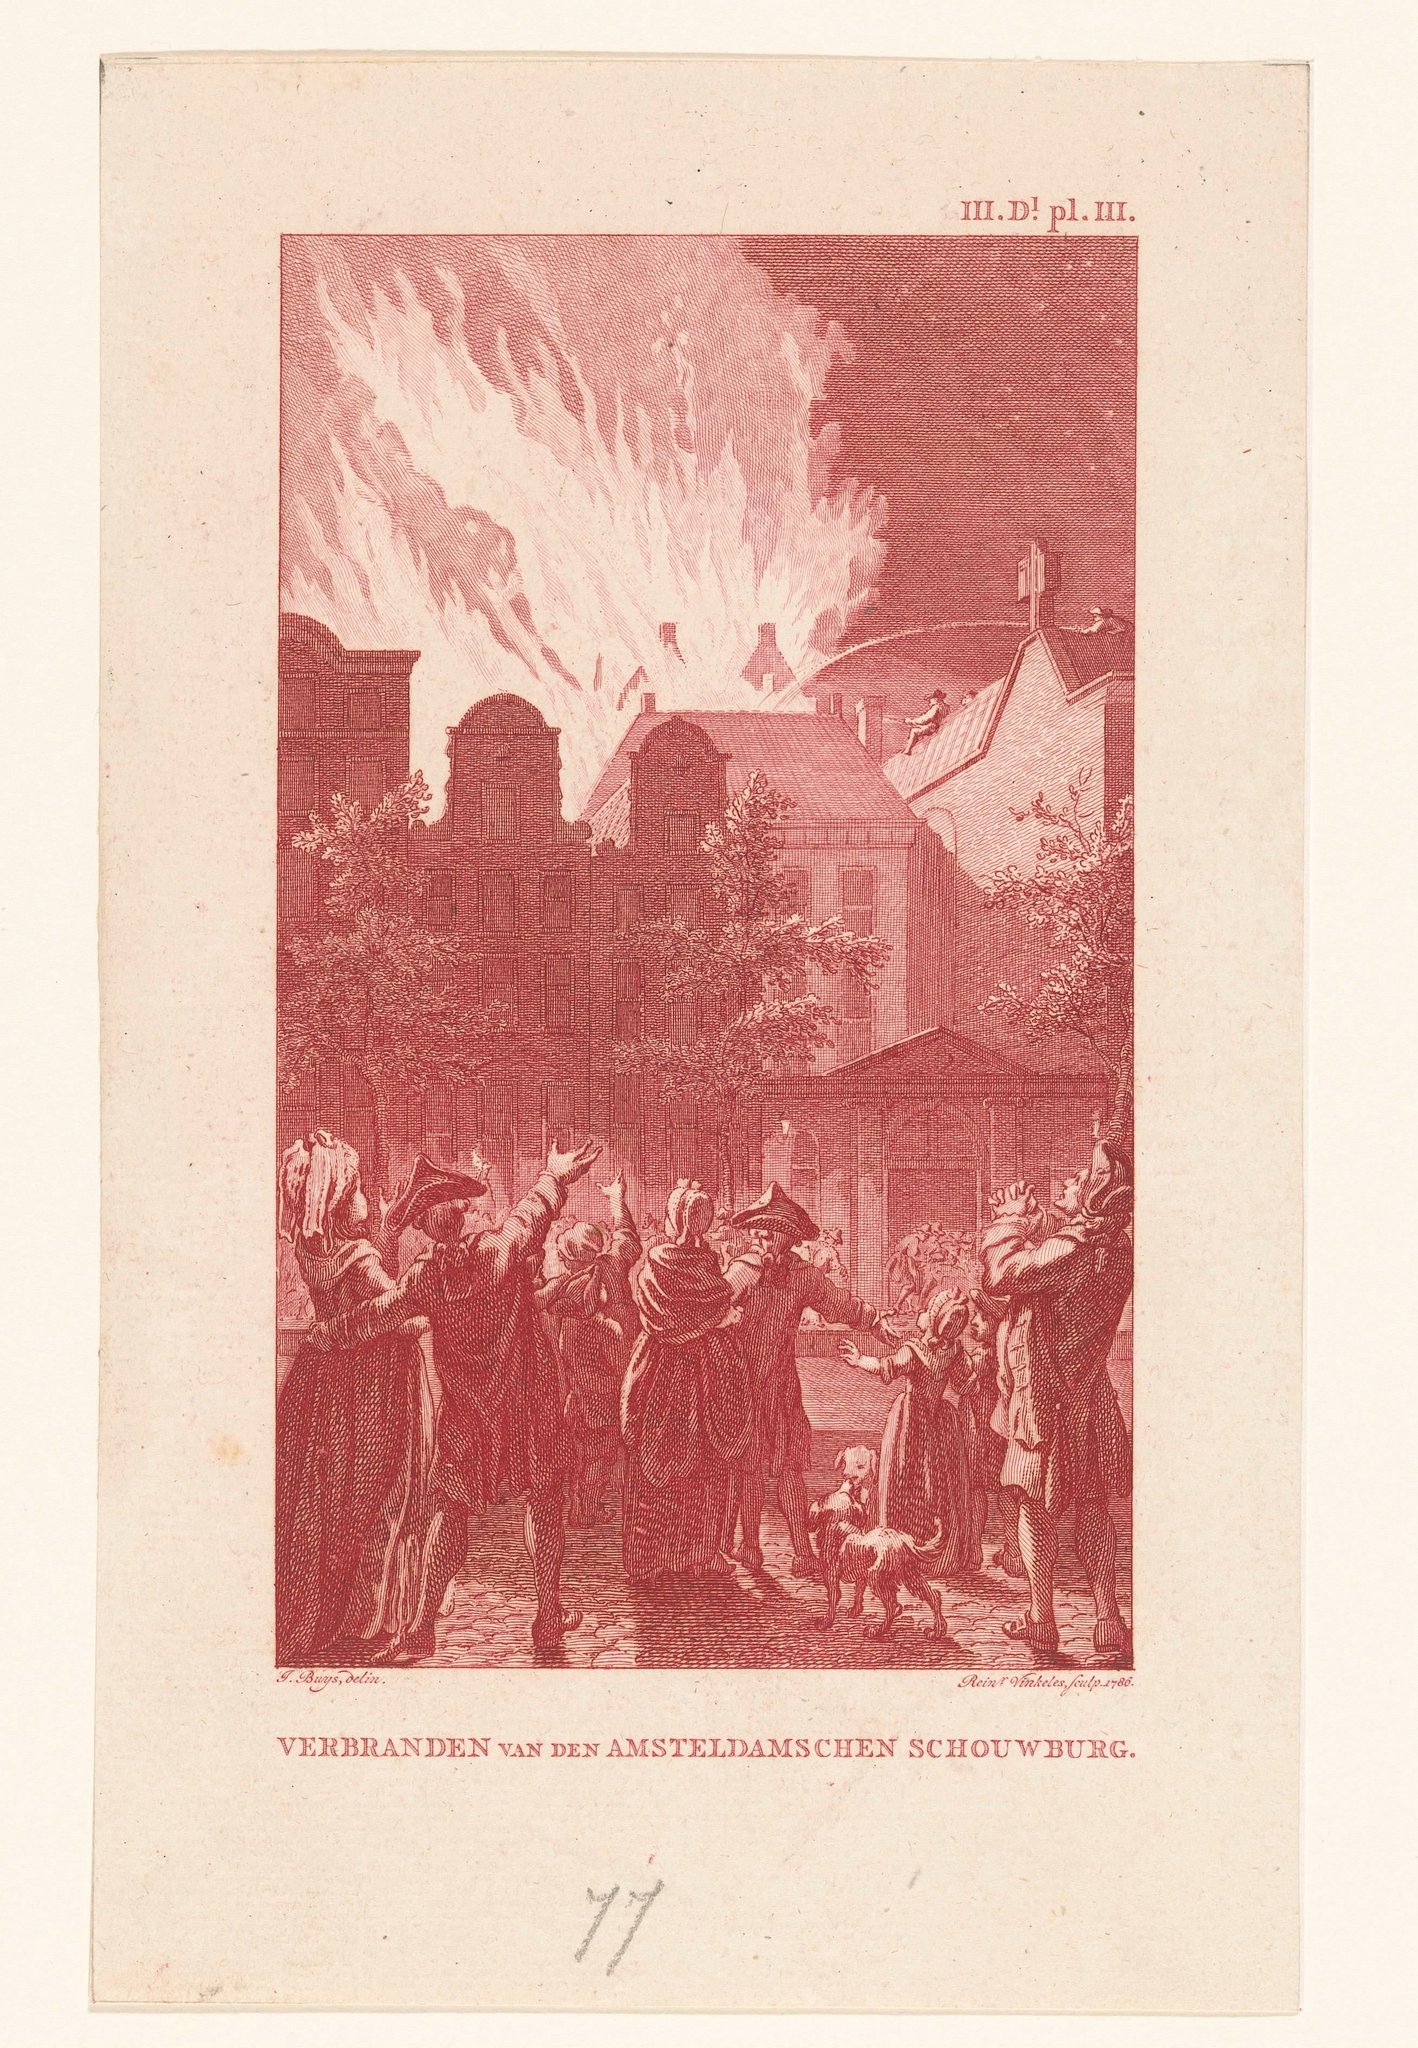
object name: book illustration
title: Brand van de schouwburg aan de Keizersgracht te Amsterdam, 1772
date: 1786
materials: paper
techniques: engraving, etching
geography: amsterdam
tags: on fire, ablaze, theatre (building), fire-fighting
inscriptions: collector's mark: Lugt 2228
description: Gezicht op de laaiende brand in de Amsterdamse Schouwburg op 11 mei 1772, gezien vanaf de overzijde van de Keizersgracht. Vanaf het dak rechts wordt getracht het vuur te blussen. Op straat vele toeschouwers. Rechtsboven genummerd: III. Dl. pl. III.